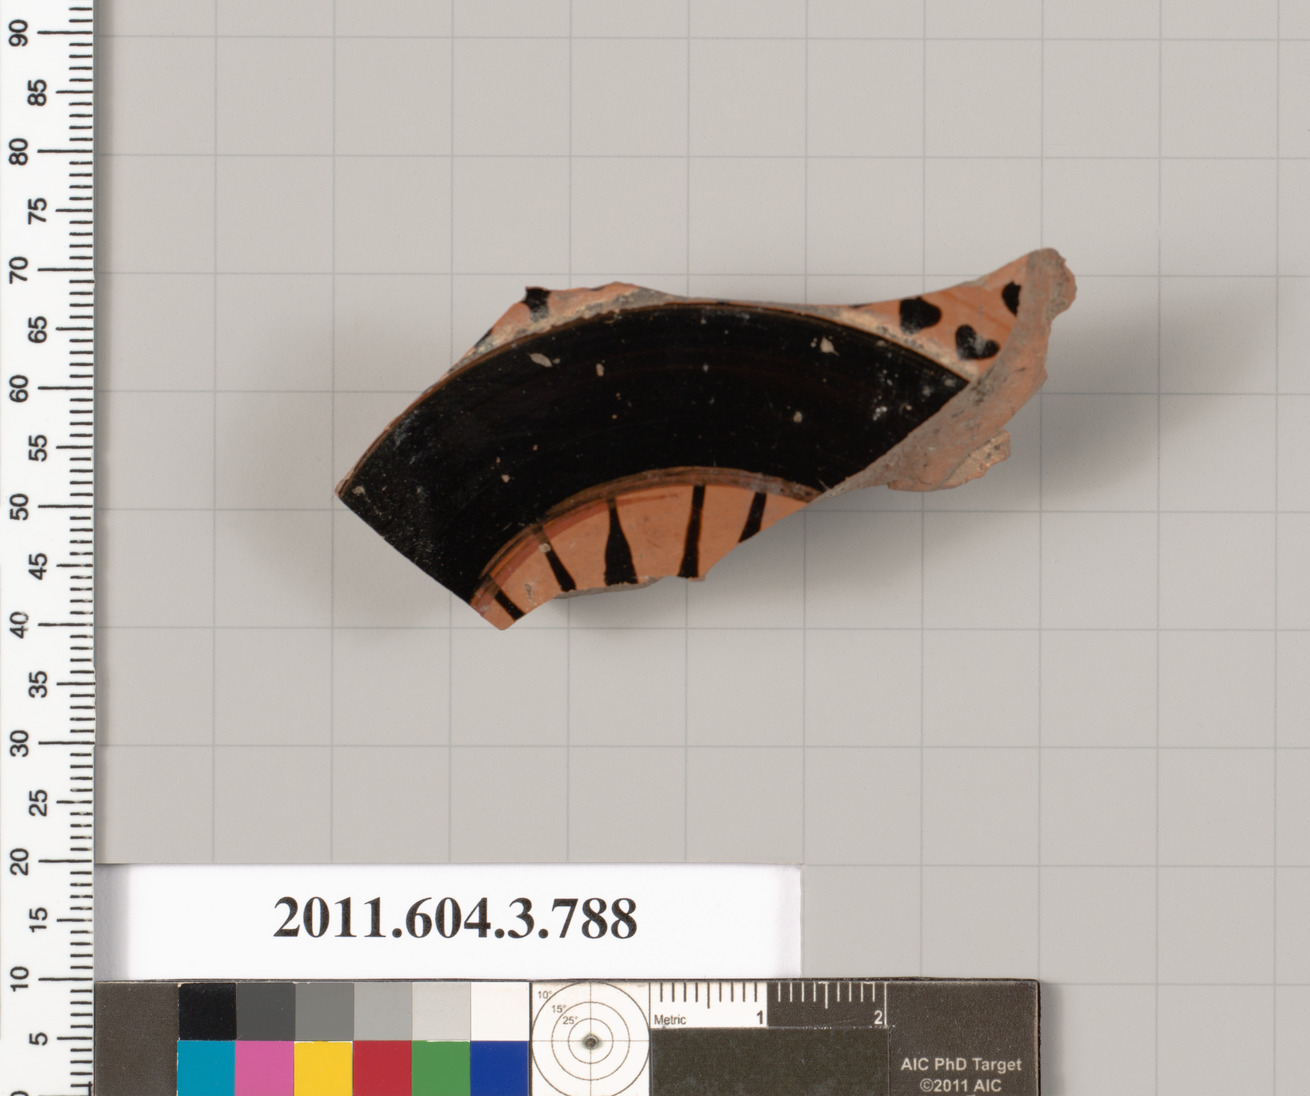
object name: lid fragment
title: Terracotta fragment of a lid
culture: greek, attic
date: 600-501 BCE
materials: terracotta